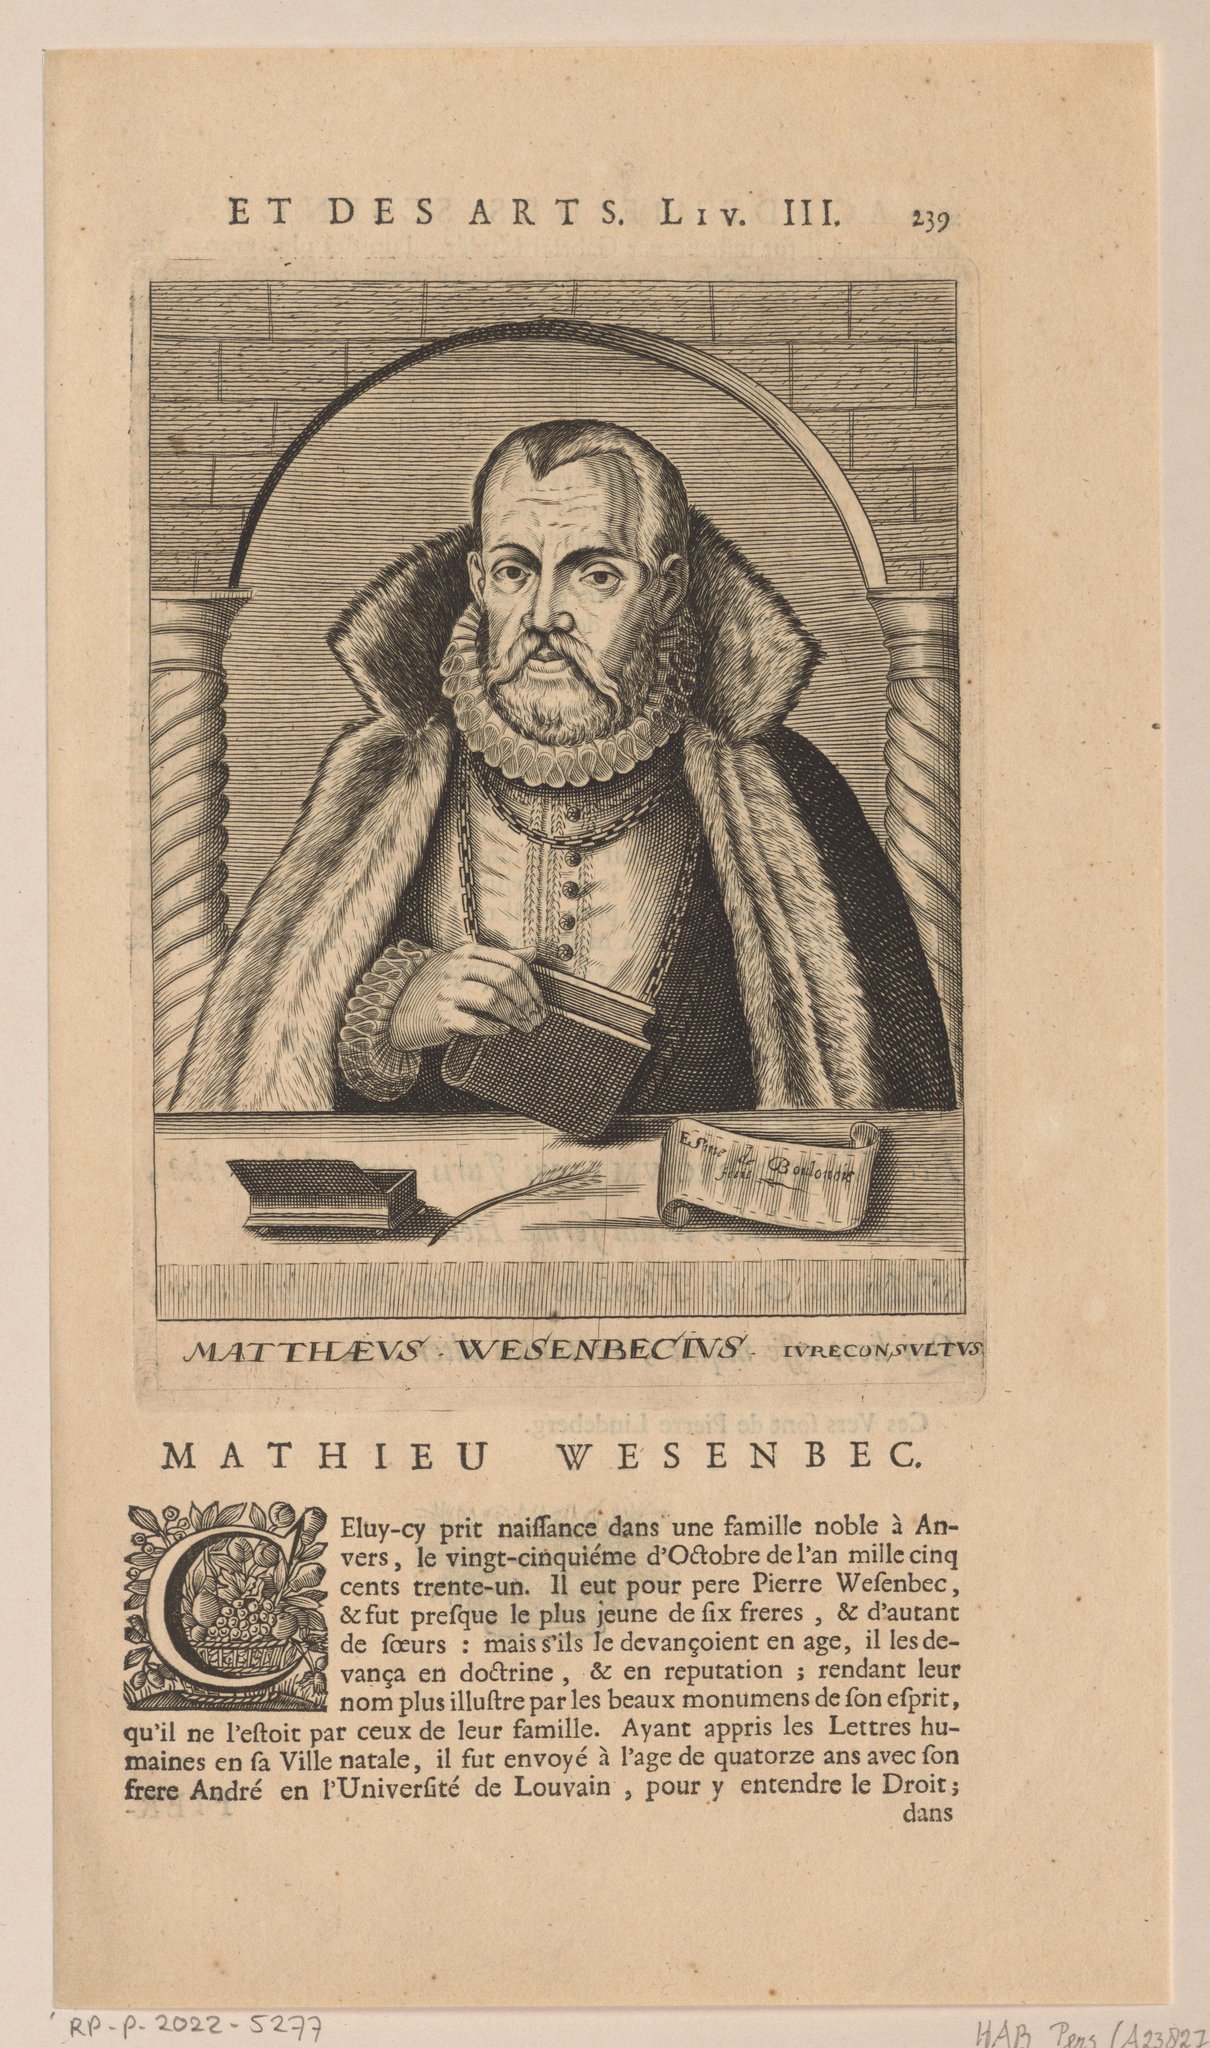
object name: book illustration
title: Portret van Matthias Wesenbeck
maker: edme de boulonois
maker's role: print maker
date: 1682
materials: paper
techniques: engraving, letterpress printing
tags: antwerp, quill, historical persons, book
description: Prent uit: Bullart, Isaac. Académie des Sciences et Arts (...). Parijs: Louis Bilaine, 1682, dl. 1, p. 239. Het boek werd in hetzelfde jaar ook uitgegeven in Brussel door François Foppens en in Amsterdam door de erfgenamen van Daniël Elzevier.